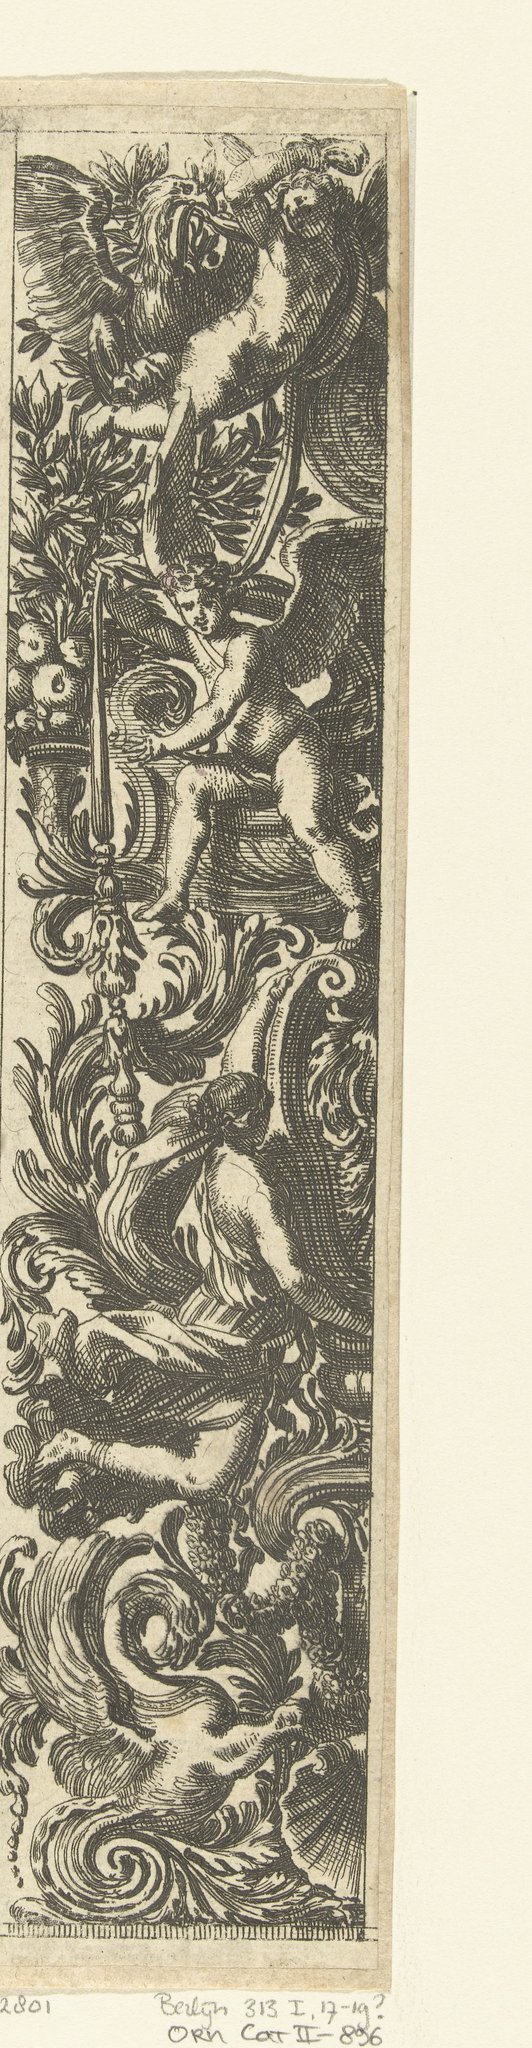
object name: ornament print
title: Paneel met putto en adelaar bovenaan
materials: paper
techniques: etching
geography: france